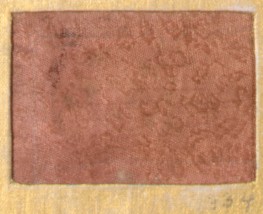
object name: piece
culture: japanese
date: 1701-1900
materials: silk